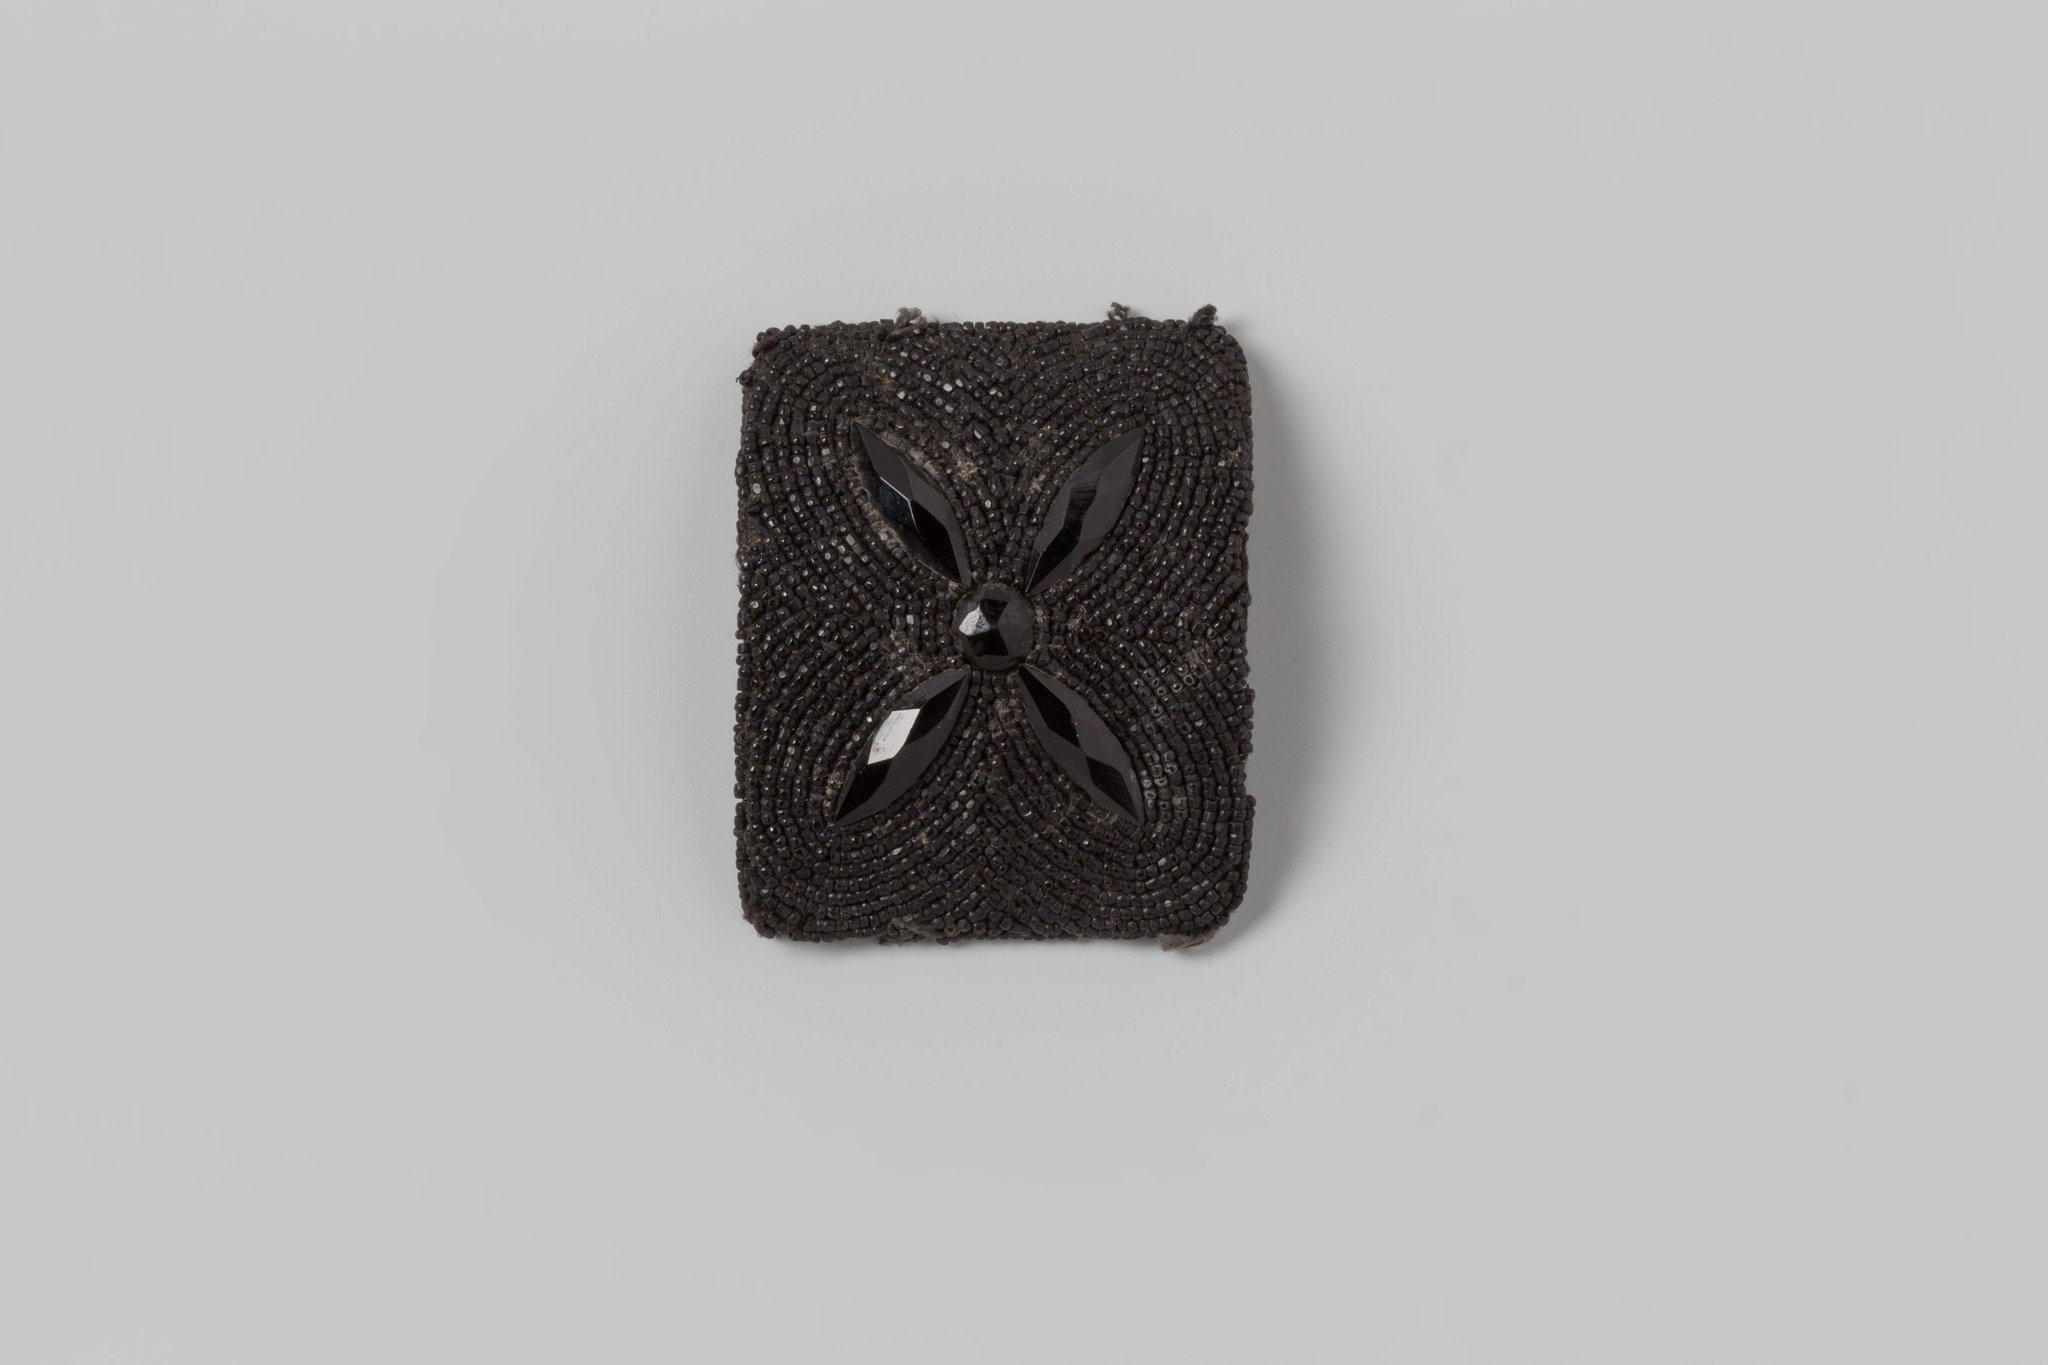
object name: buckle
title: Gesp van gitten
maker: Anonymous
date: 1900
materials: jet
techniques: sewing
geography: france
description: Gesp van gitten. Rechthoekig gesloten model, gevuld met een gitten vierpuntige ster, die concentrisch omgeven is door kleinere gitten.